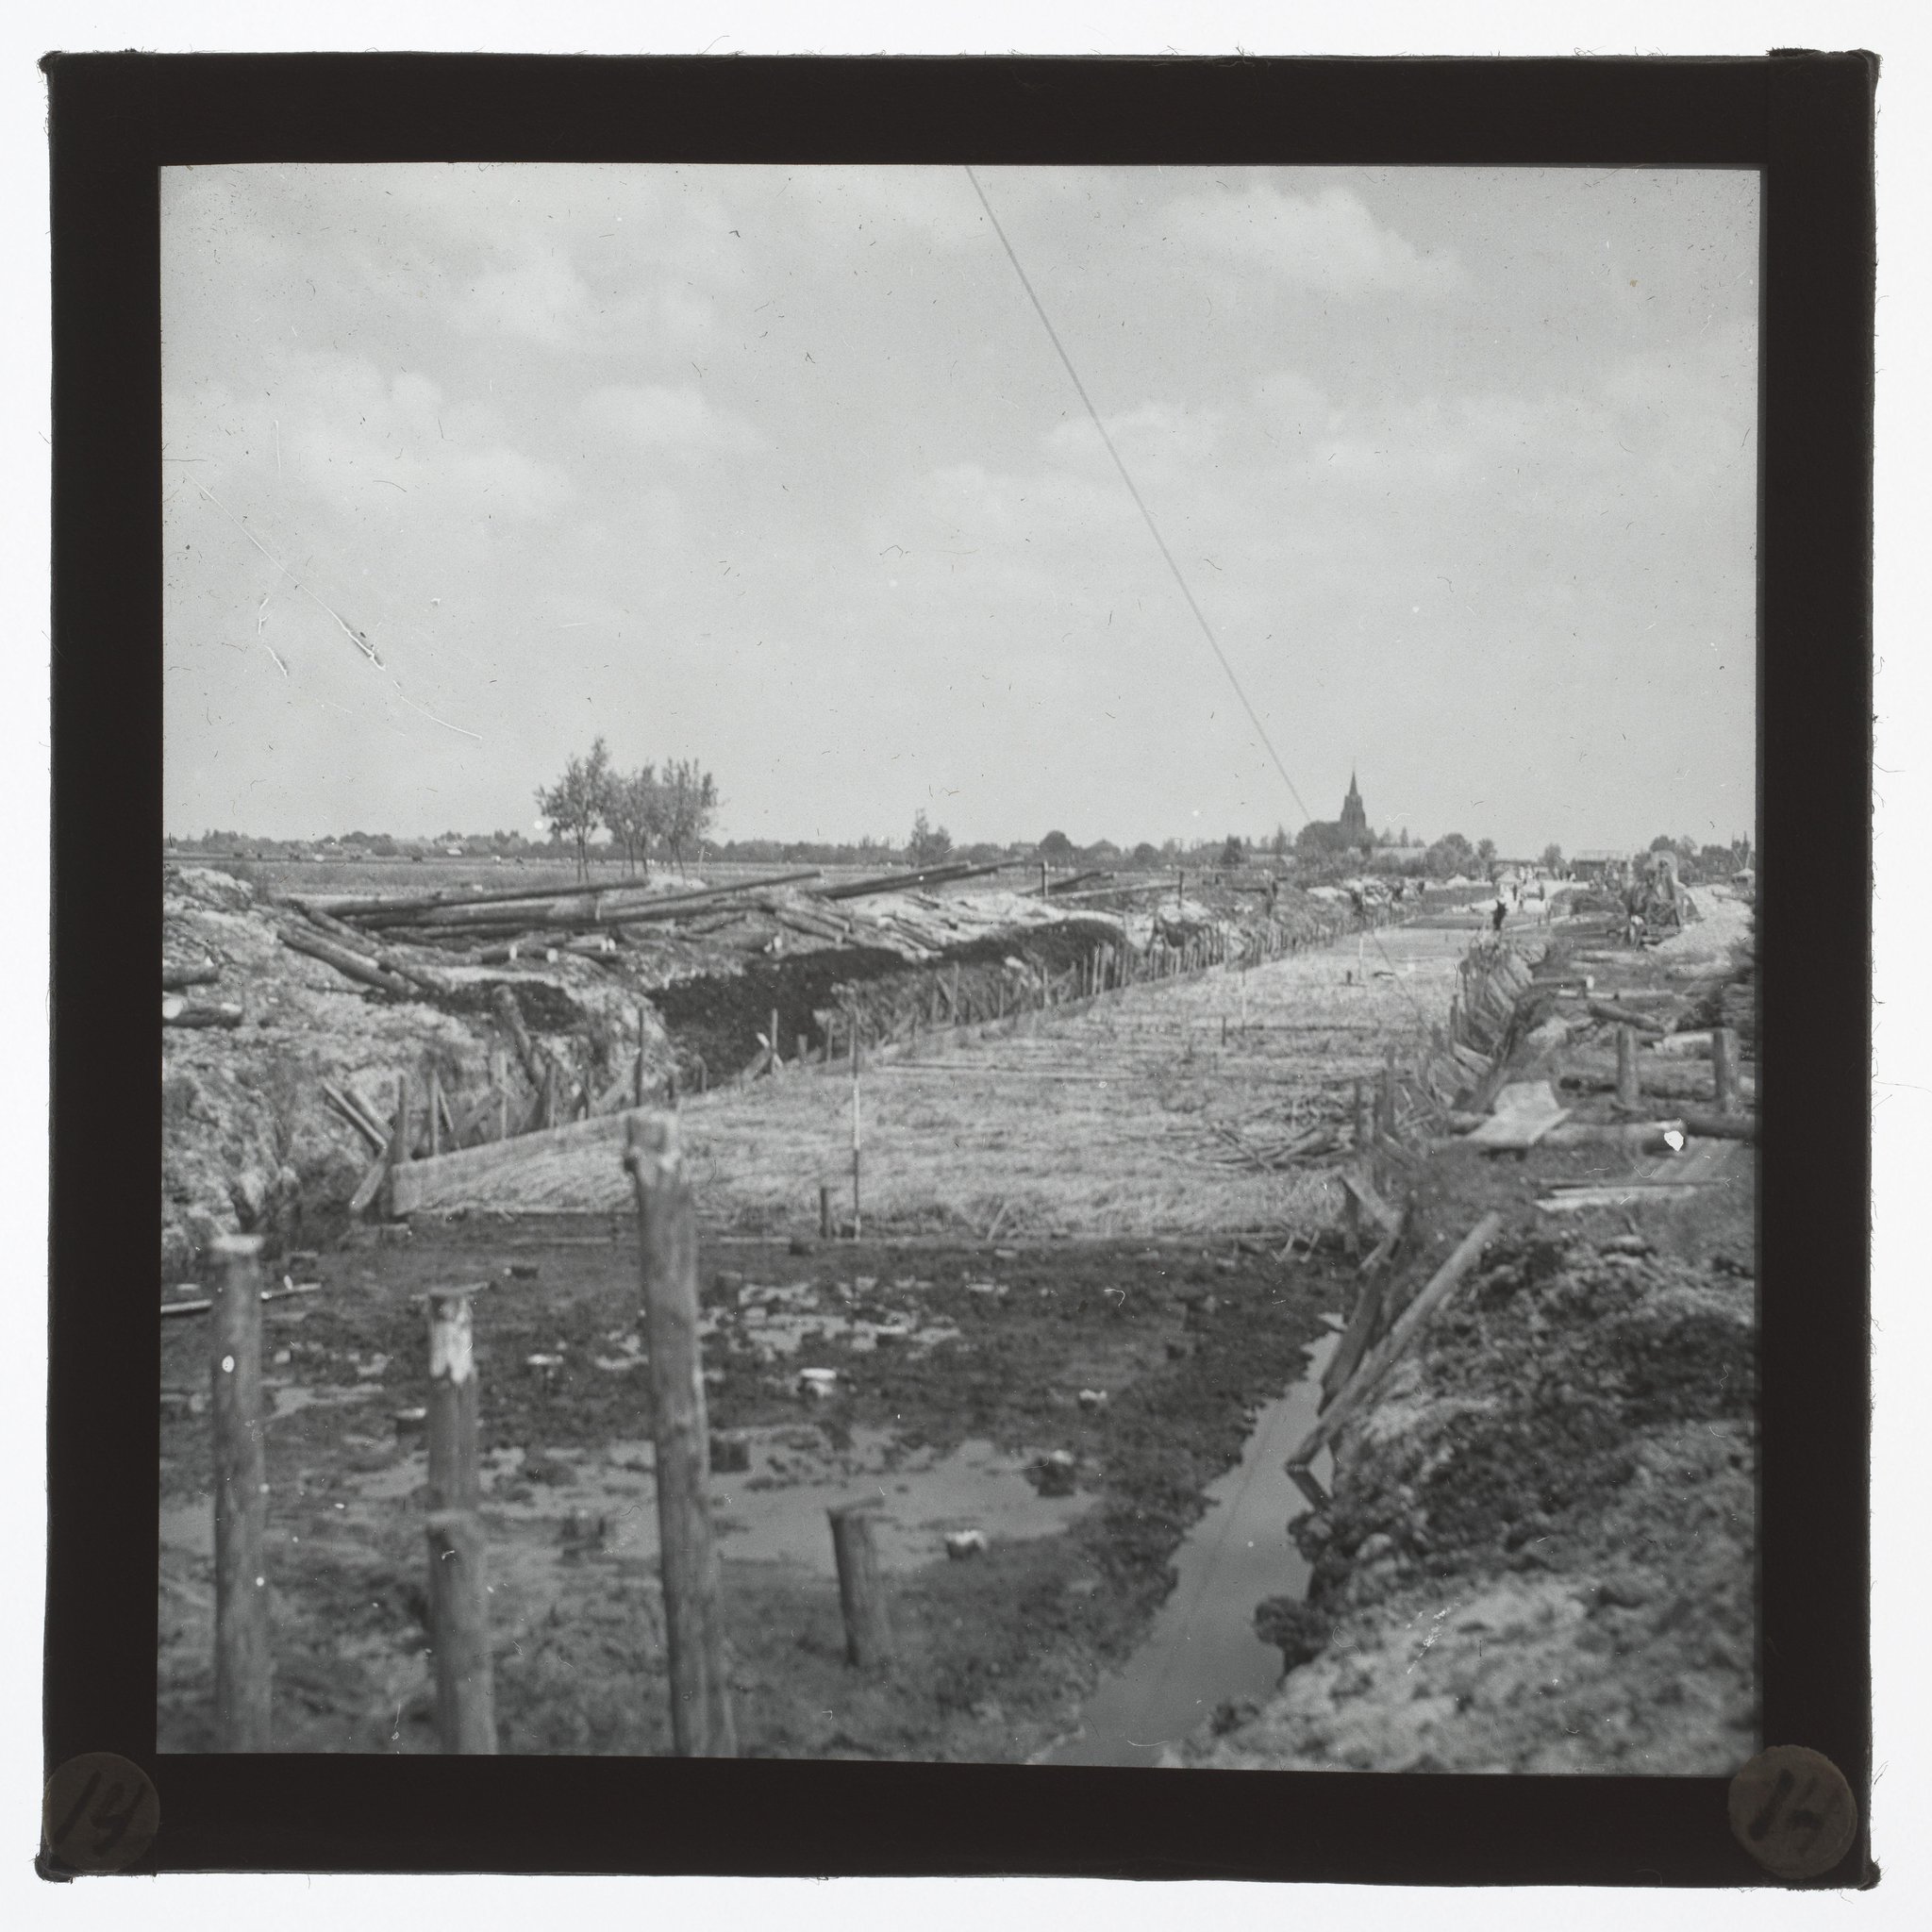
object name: lantern slide photographic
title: Gezicht op een bouwplaats, Zuid-Holland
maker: Anonymous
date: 1956-1960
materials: glass, paper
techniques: gelatin silver transparency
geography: south holland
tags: building-site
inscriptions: number: ‘14’